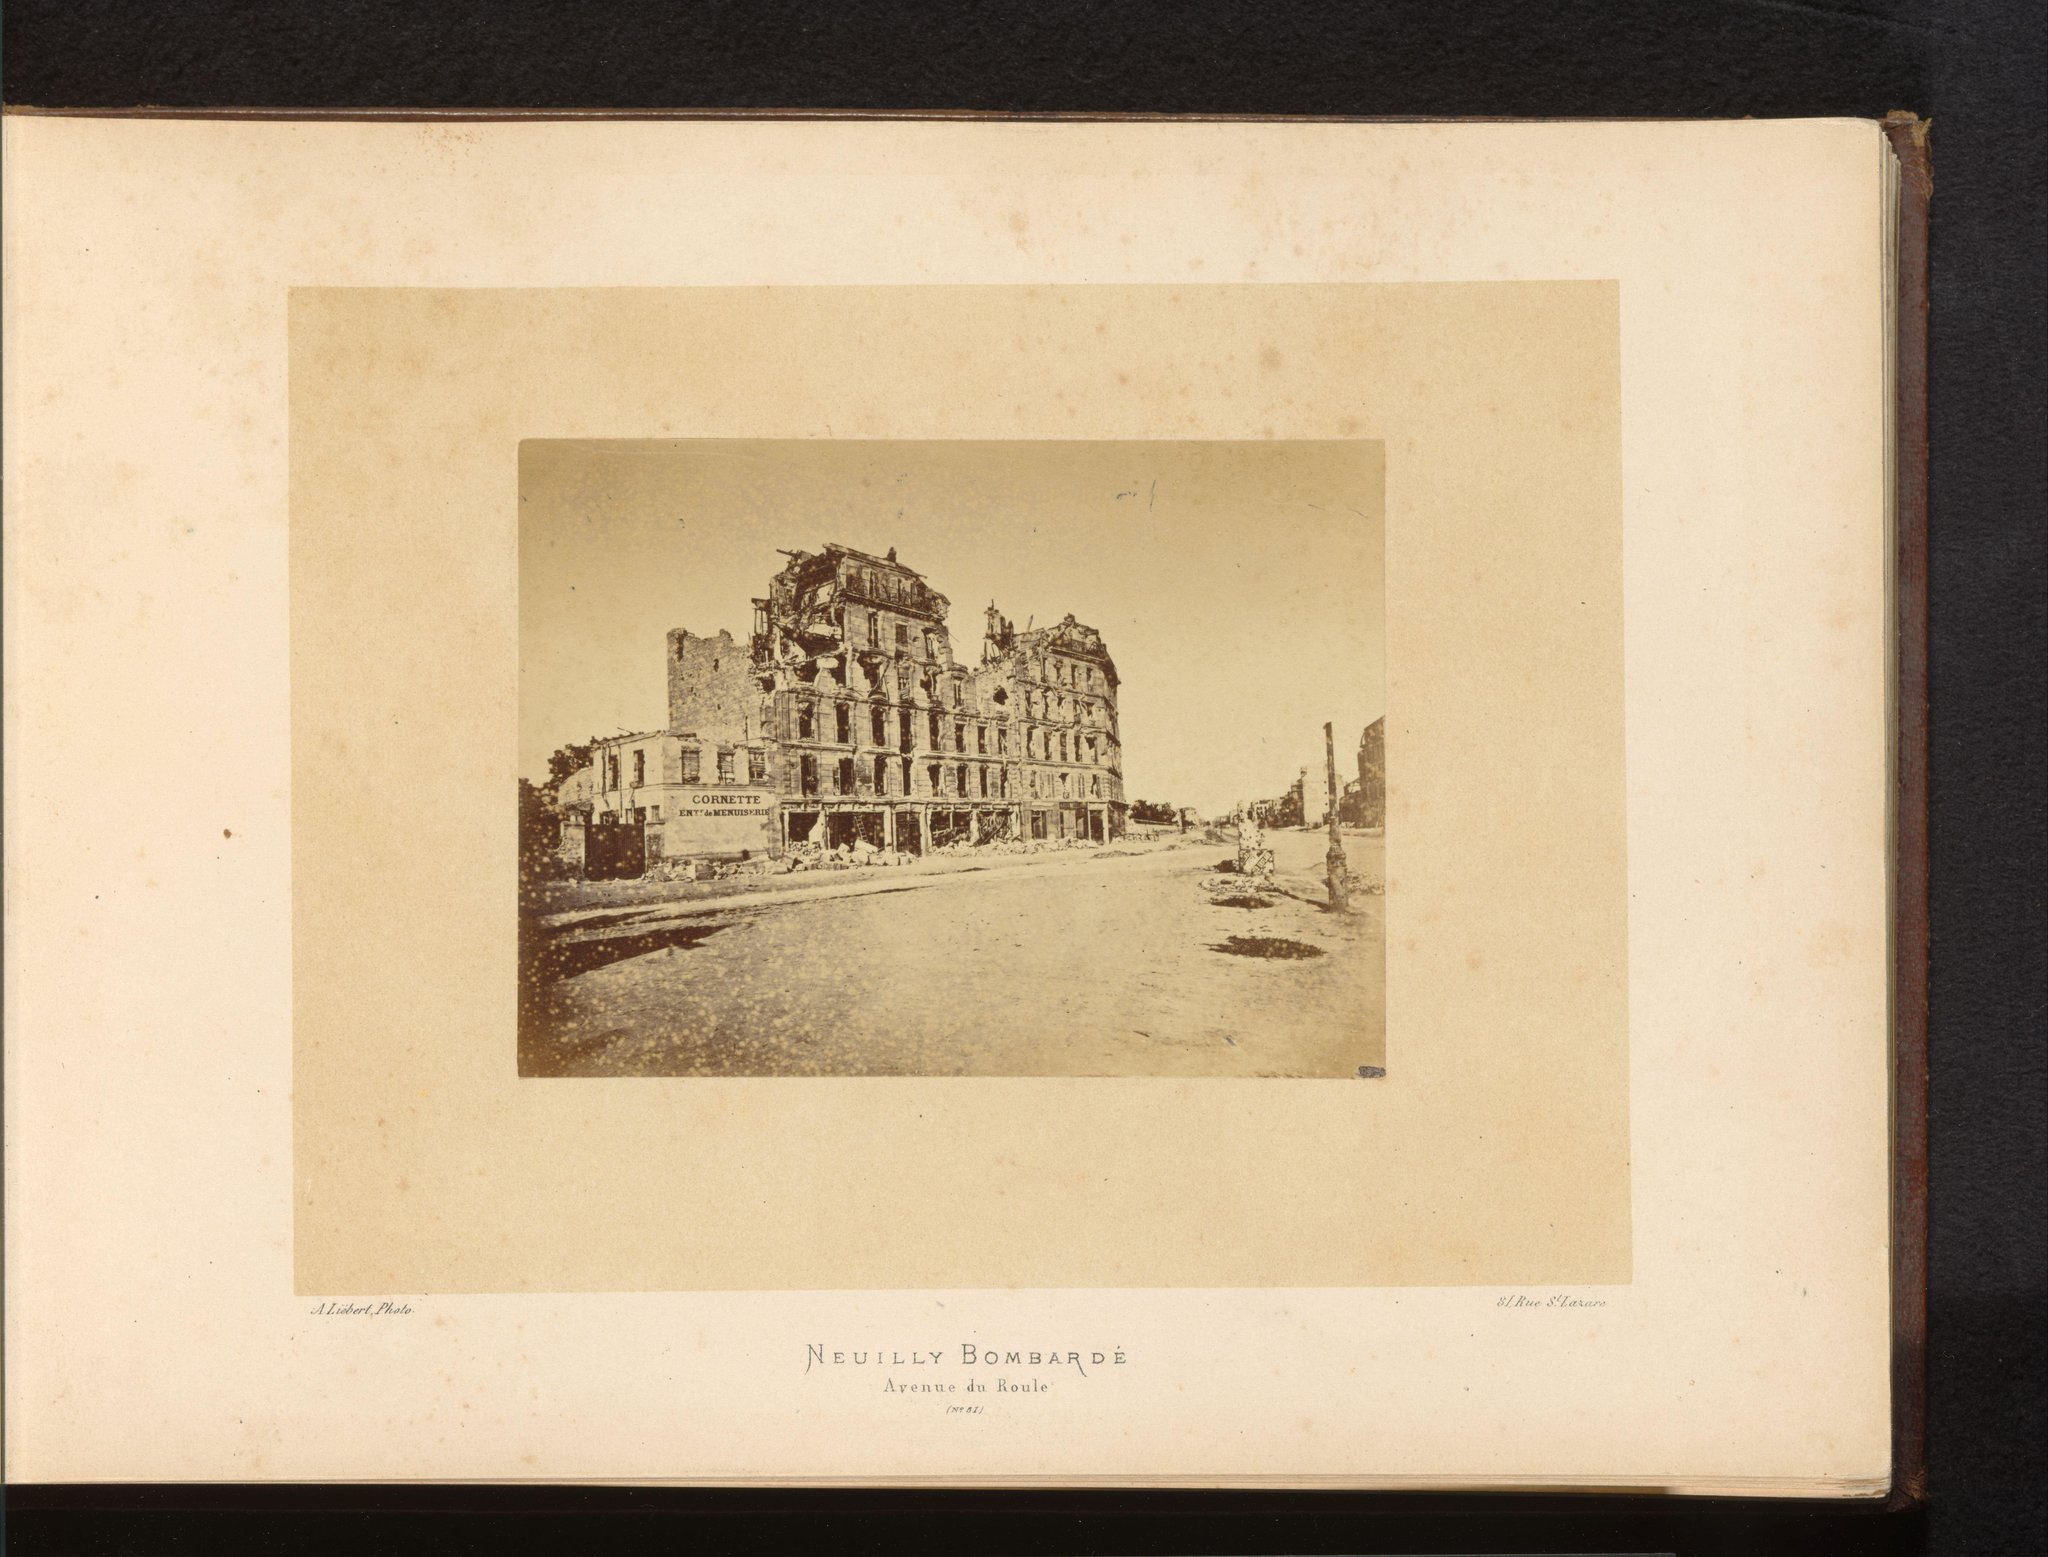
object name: photograph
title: Neuilly Bombardé. Avenue du Roule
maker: alphonse-justin liébert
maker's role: fotograaf, marinier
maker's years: 1827-1914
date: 1871-1872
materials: photographic support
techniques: albumen print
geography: neuilly-sur-seine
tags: ruin of a building ~ architecture, civic architecture; edifices; dwellings, street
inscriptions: number: ‘(No. 51)’, address: ‘31, Rue St. Lazare’